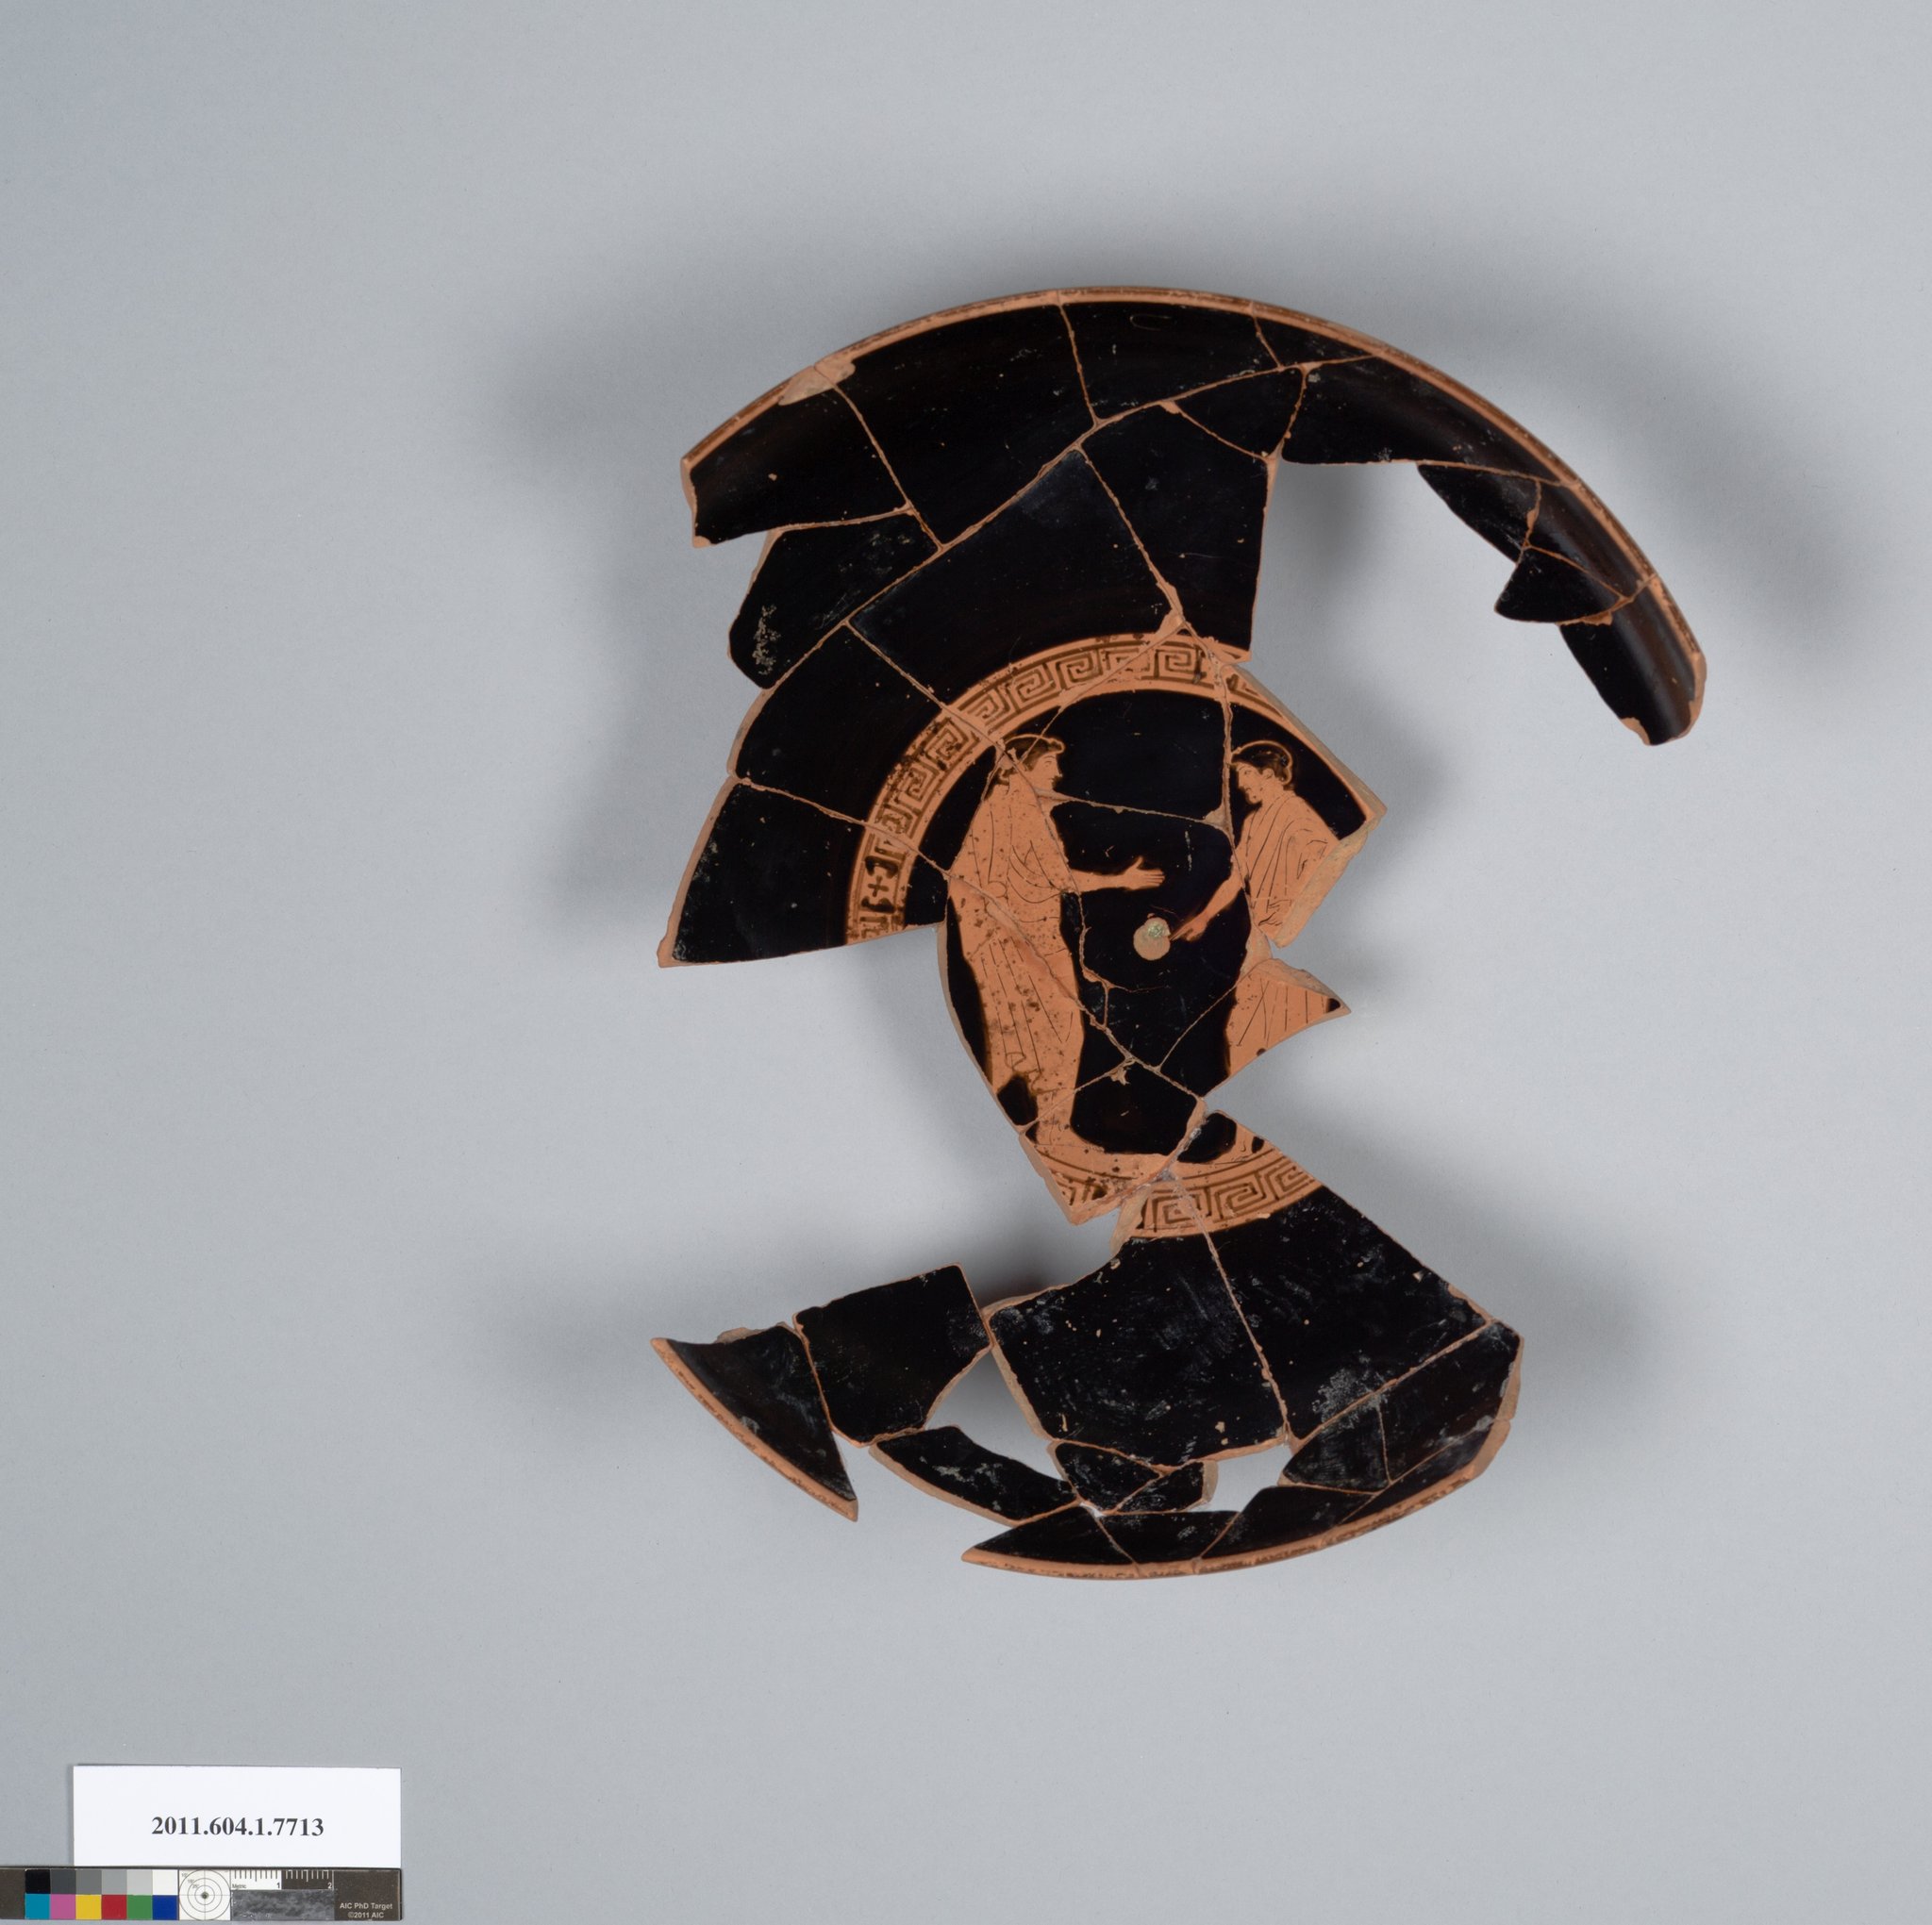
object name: kylix fragment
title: Terracotta fragment of a kylix (drinking cup)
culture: greek, attic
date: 460-450 BCE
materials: terracotta